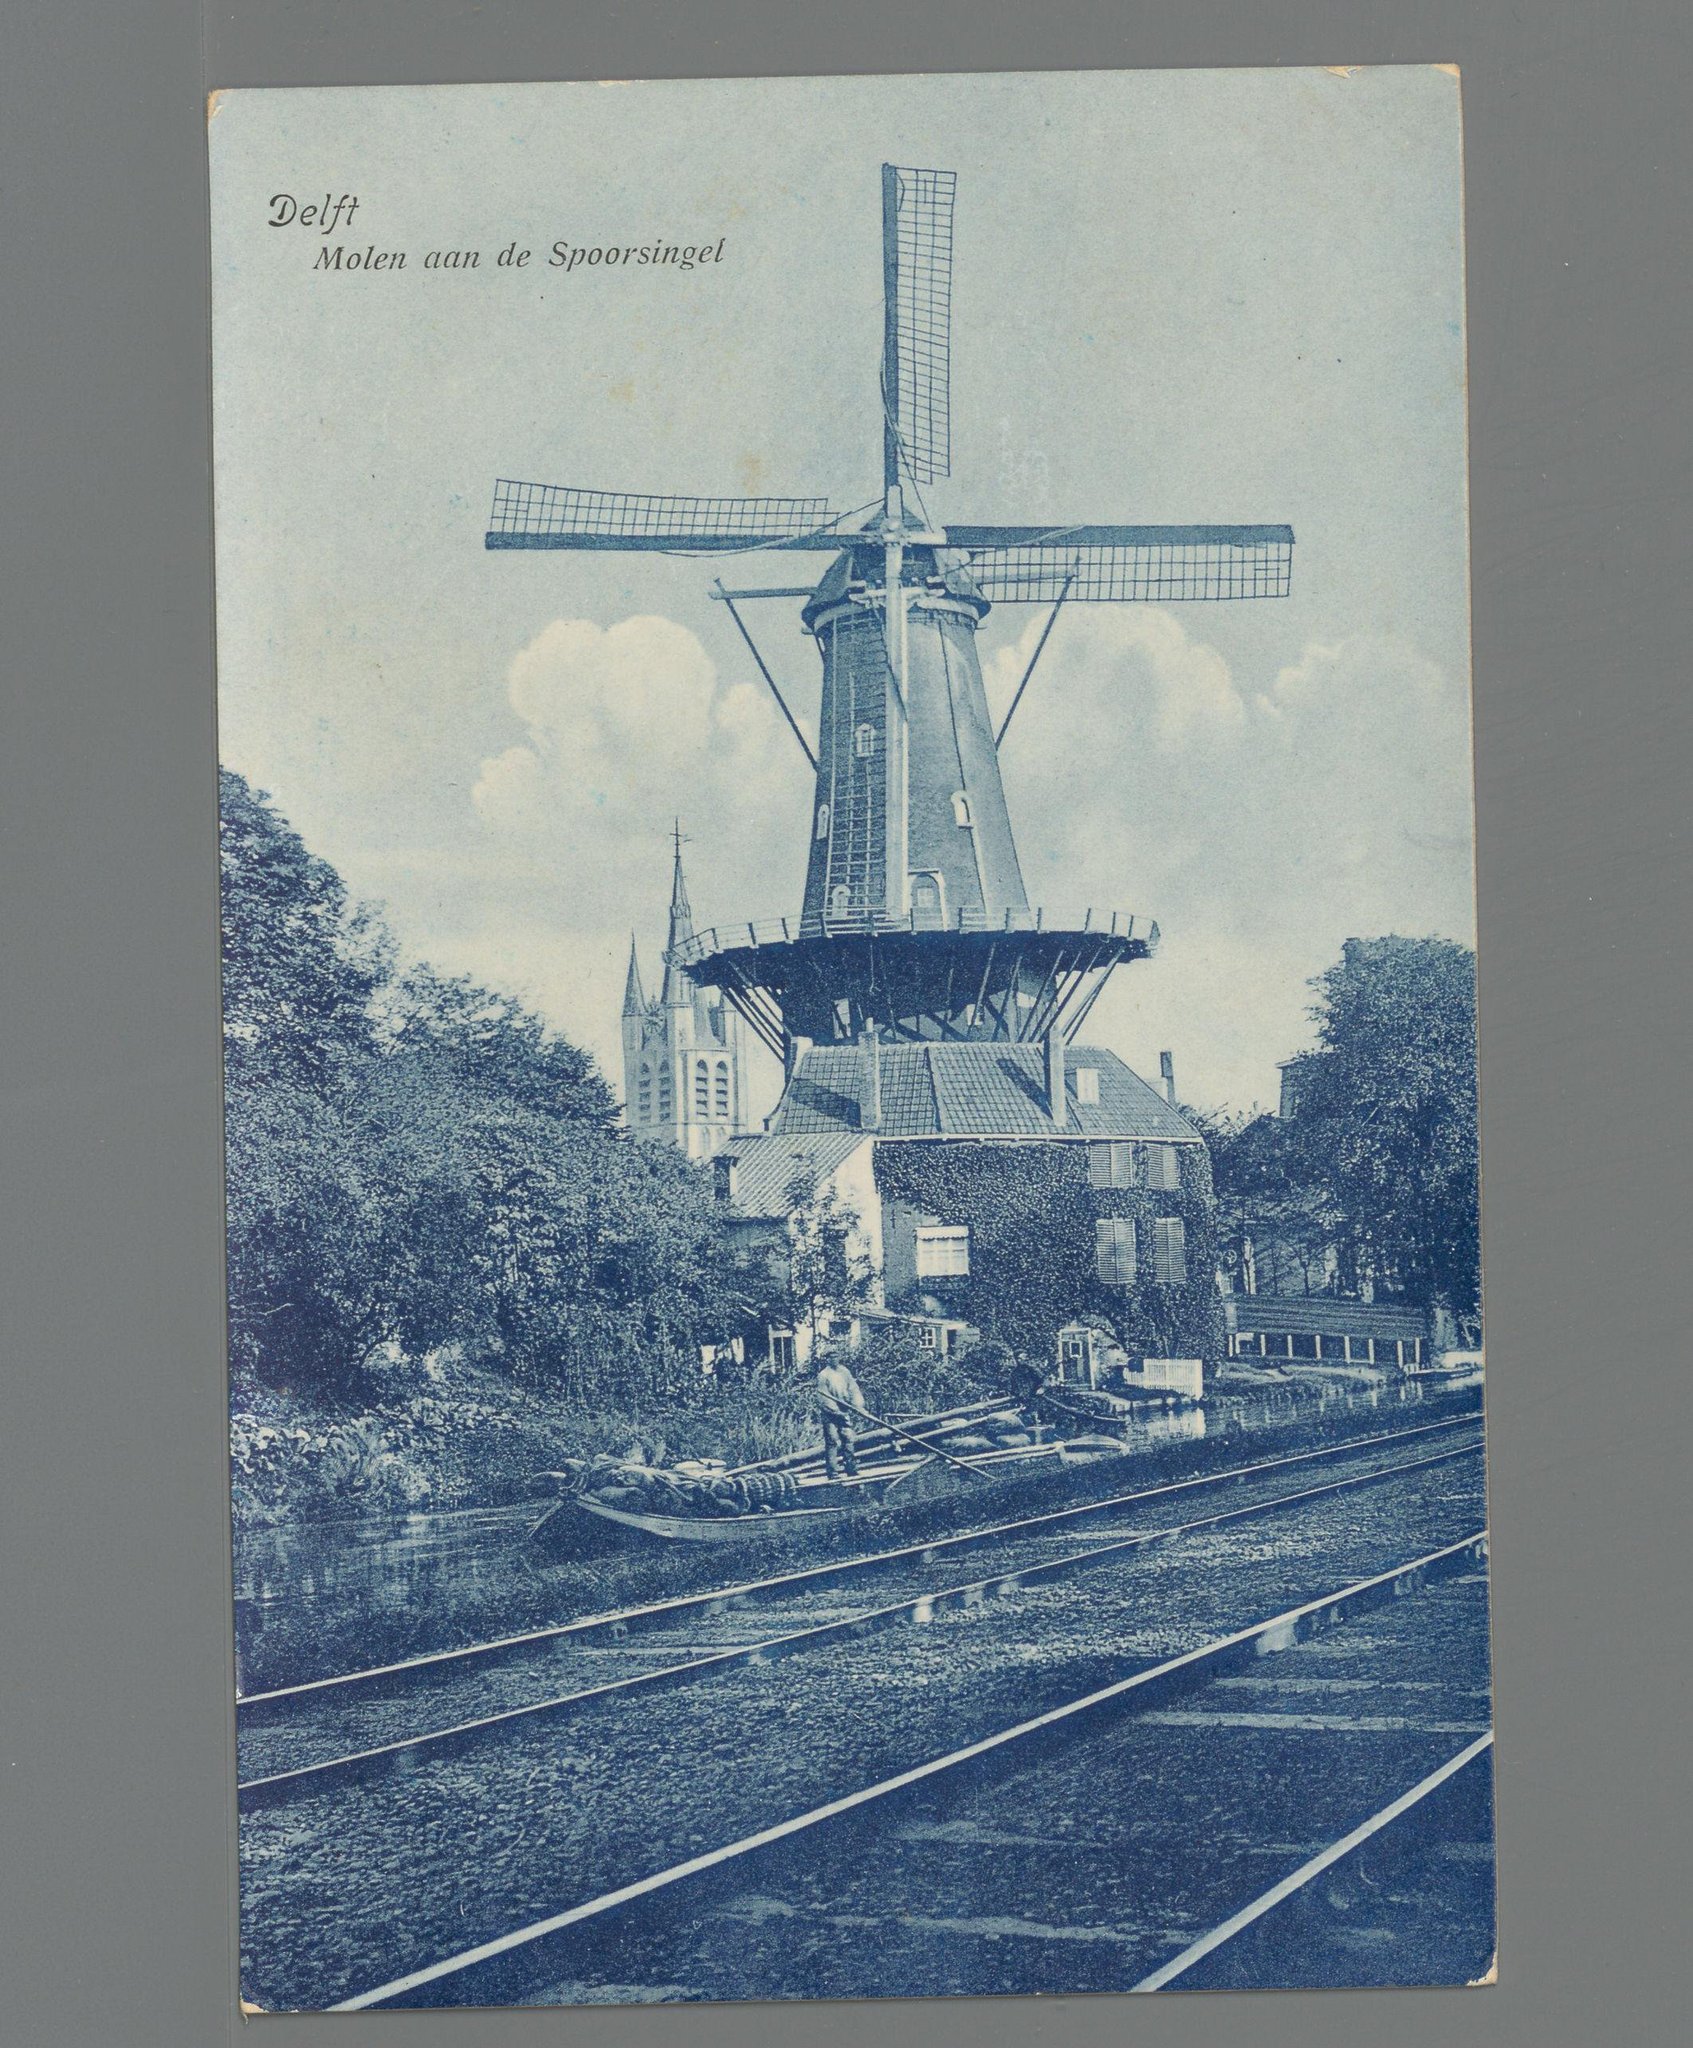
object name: photomechanical print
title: Delft. Molen aan de Spoorsingel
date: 1909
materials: cardboard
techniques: photograph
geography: delft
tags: canal, church (exterior), railway, train, windmill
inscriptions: date